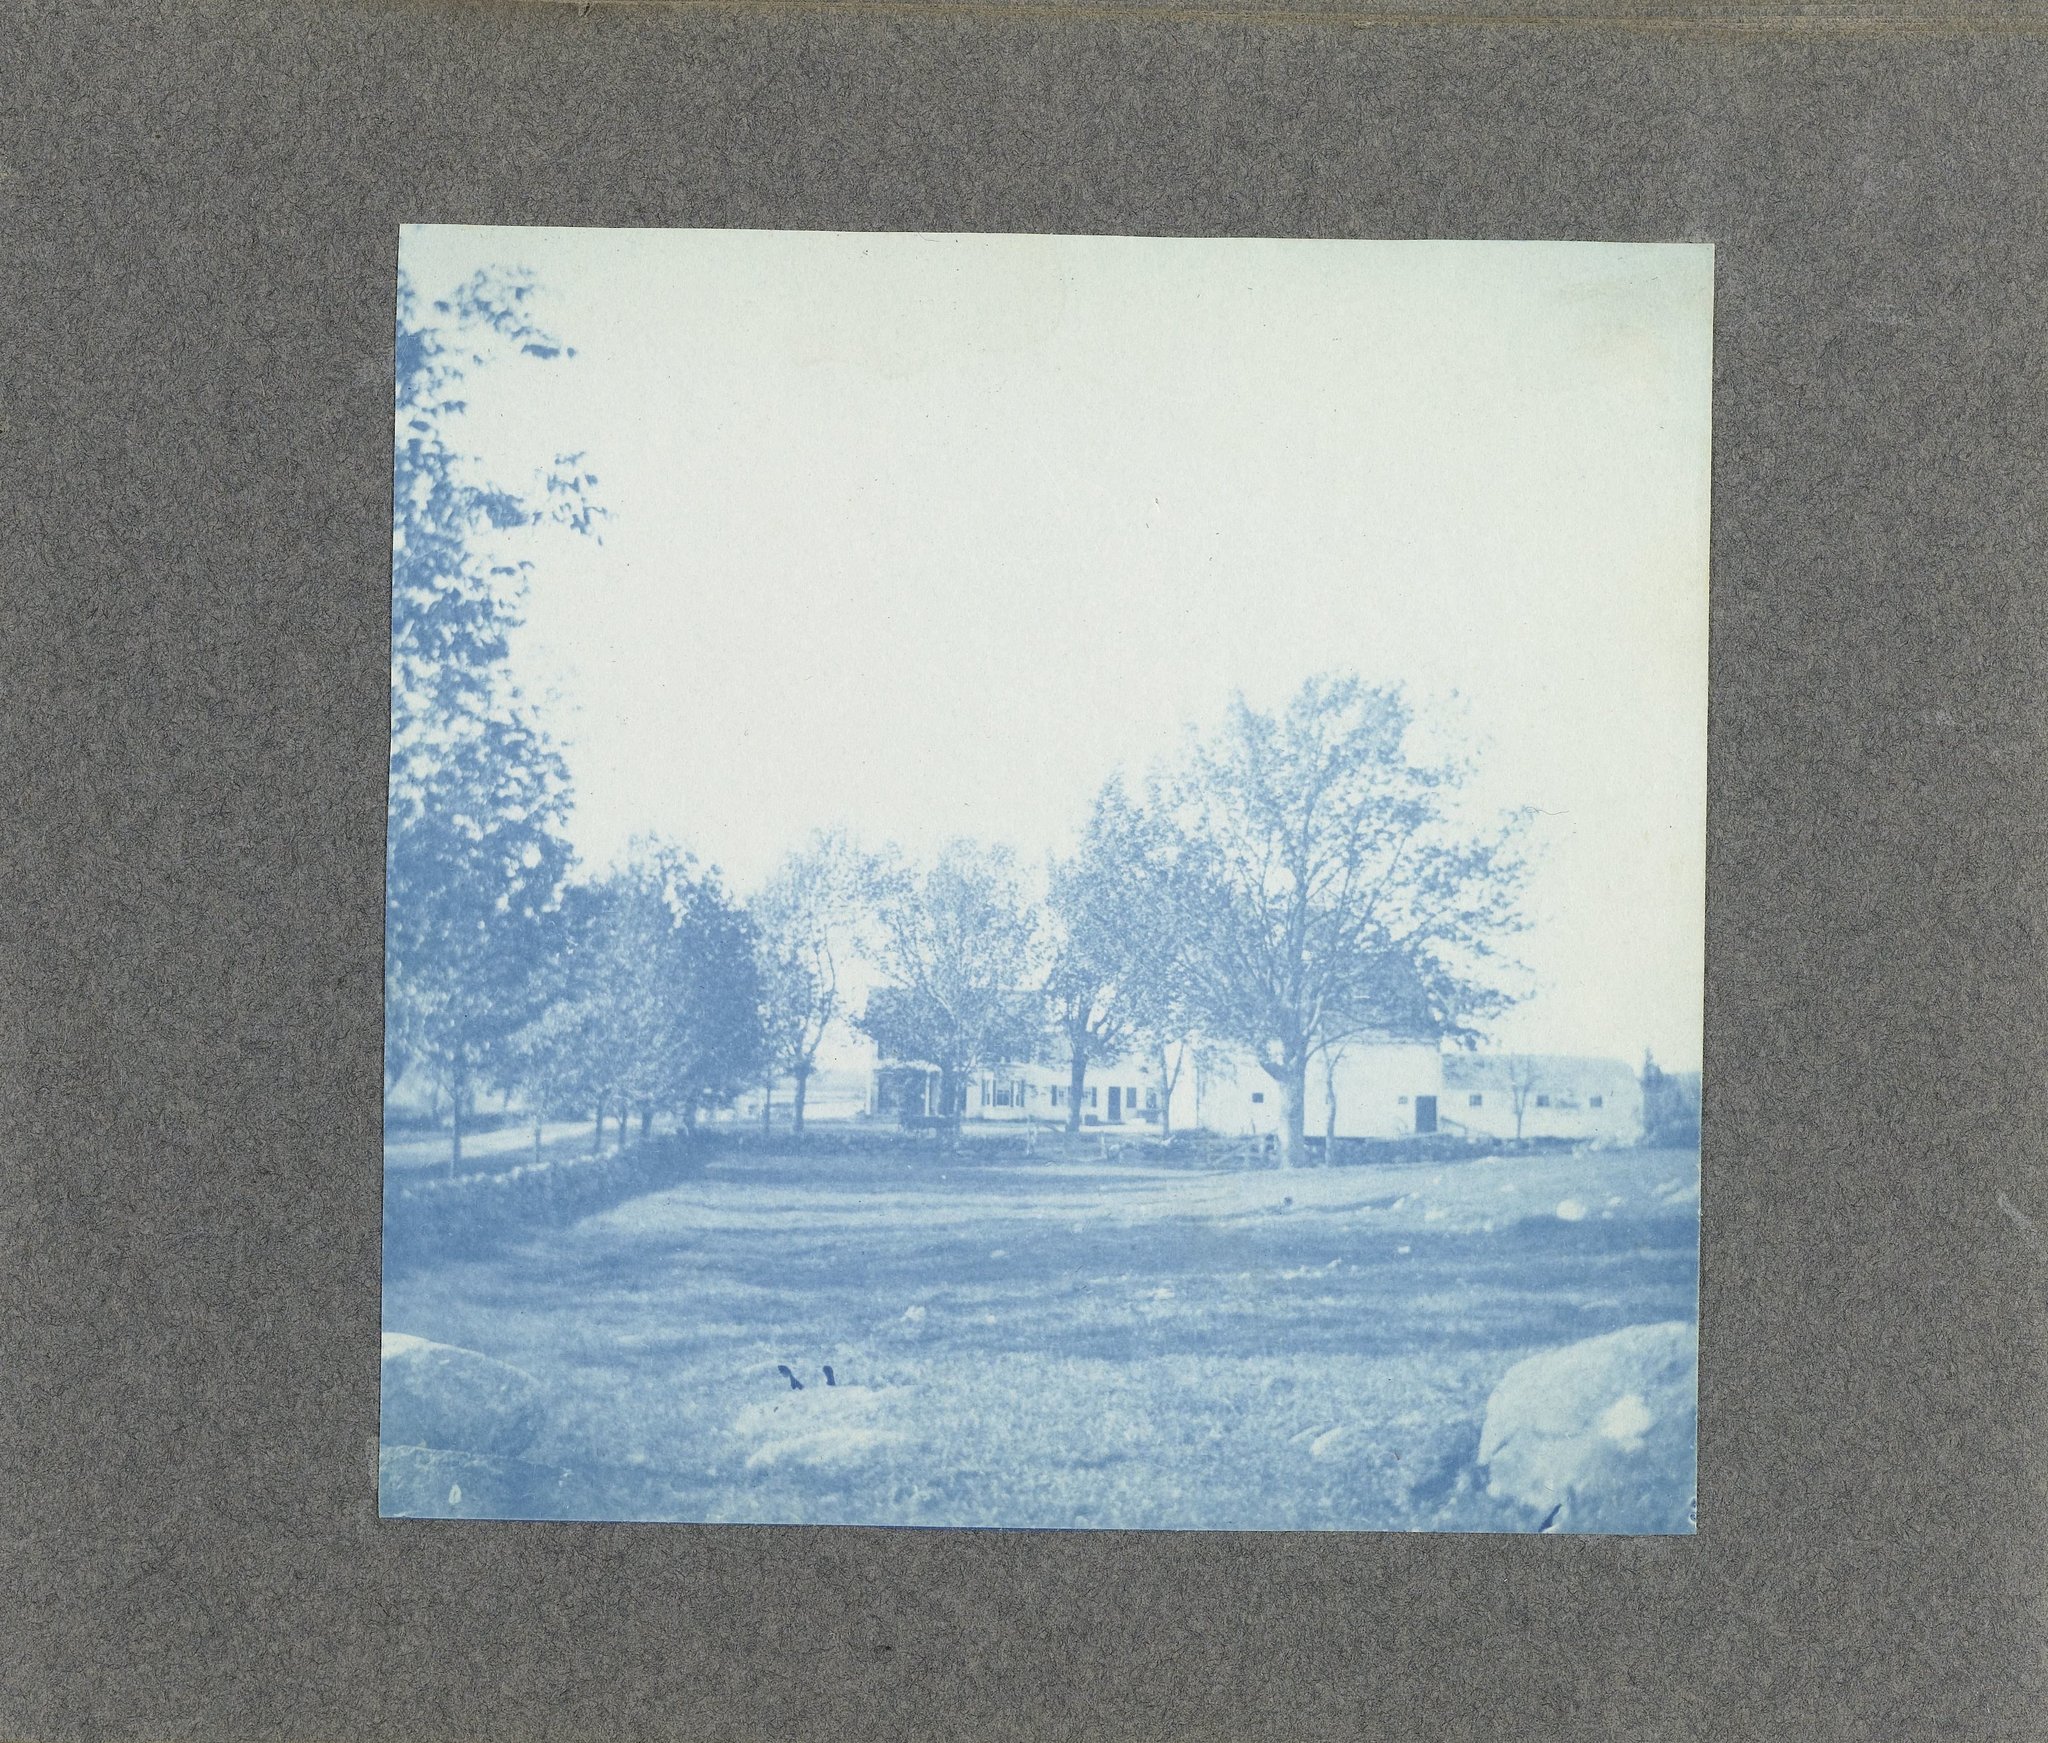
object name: photograph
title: Landschap met een boerderij, Verenigde Staten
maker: Anonymous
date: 1900-1920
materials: paper, photographic support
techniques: cyanotype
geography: united states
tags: farm (building), united states of america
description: Onderdeel van Fotoalbum met 53 cyanotypieën van kinderen, paarden, huizen, boten en strandtaferelen in de Verenigde Staten.